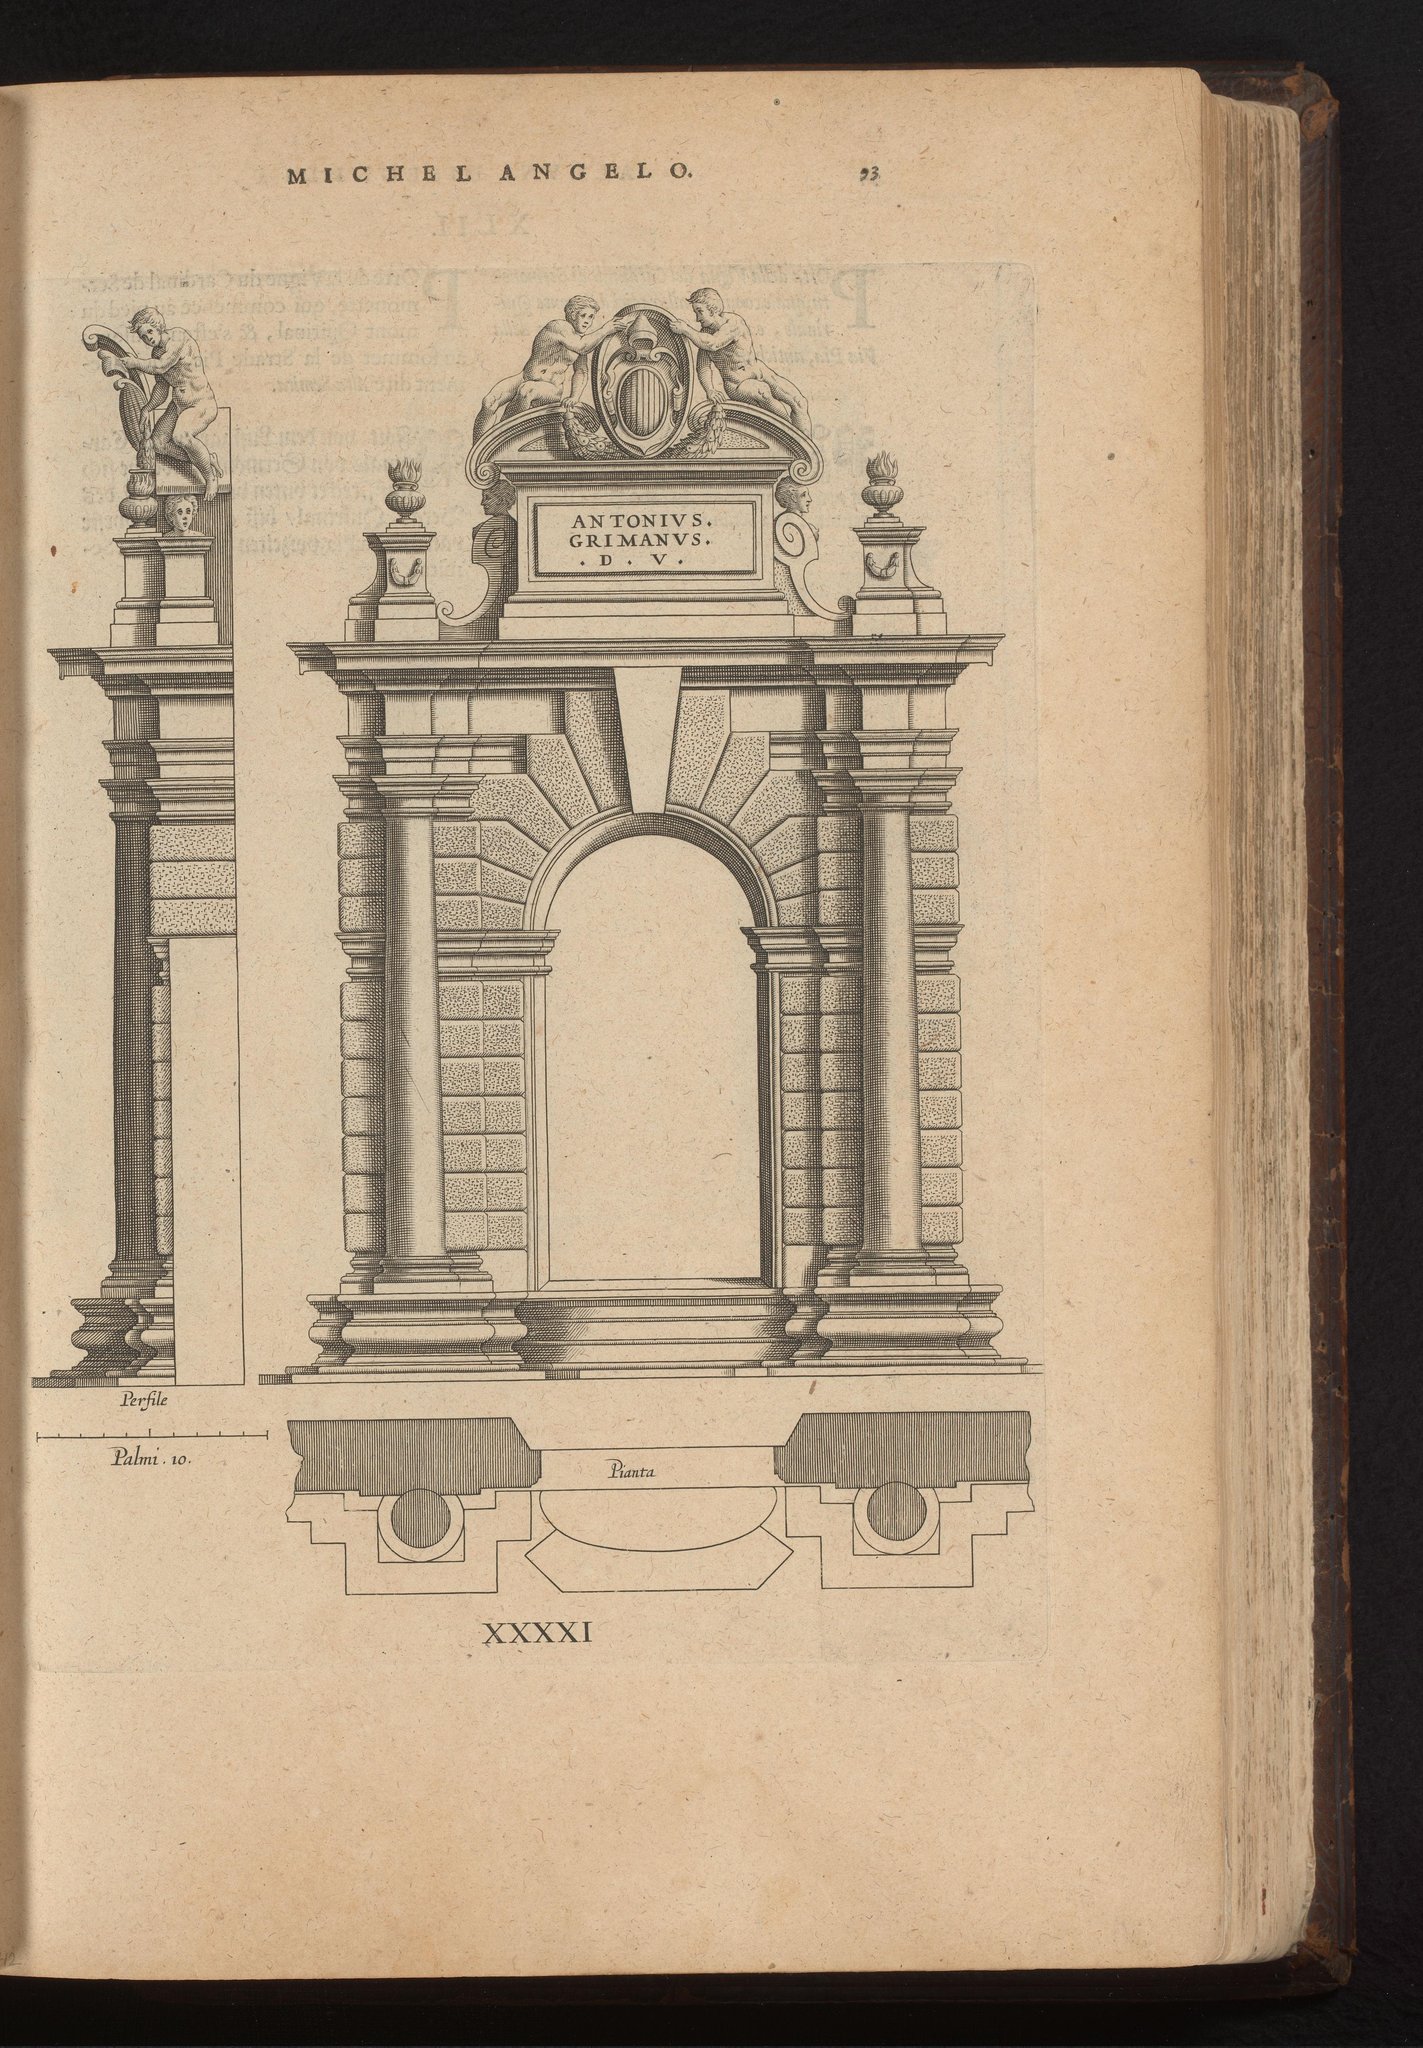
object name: book illustration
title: Poort van de tuin van doge Antonio Grimani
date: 1640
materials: paper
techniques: engraving, letterpress printing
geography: amsterdam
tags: gate, entrance, architecture, armorial bearing, heraldry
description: Prent uit: Vignola, Giacomo Barozzi da. Regola delli cinque ordini d'architettura (...). Amsterdam: Johannes Willemszoon en Cornelis Blaeu, 1640, p. 93.